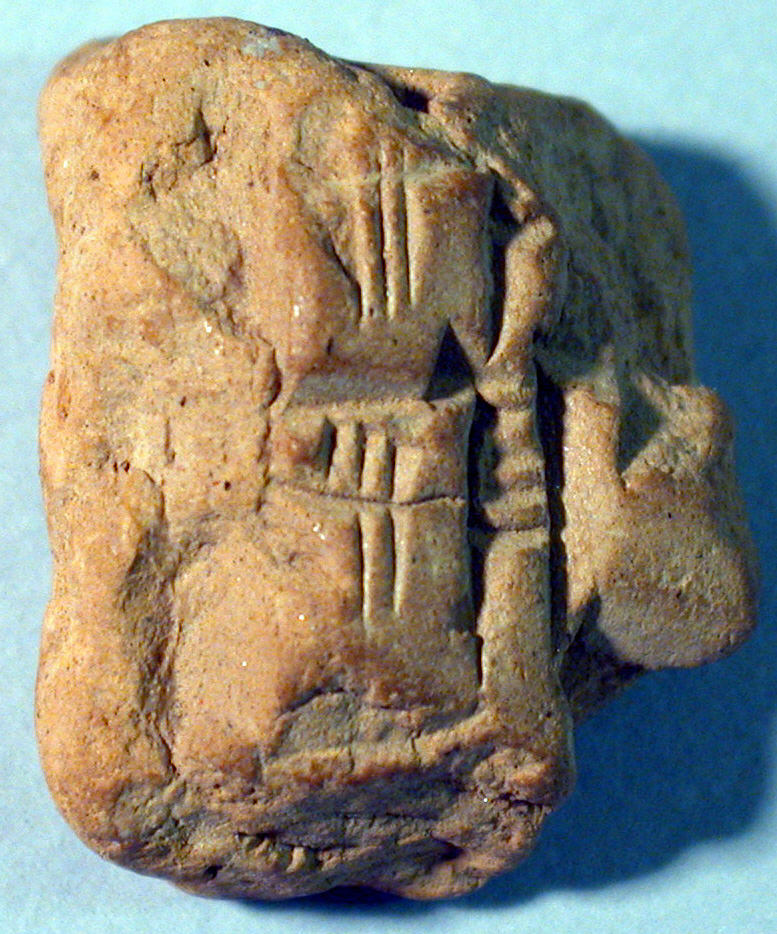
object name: cuneiform tablet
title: Cuneiform tablet: fragment of Syllabary A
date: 333-1 BCE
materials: clay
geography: mesopotamia